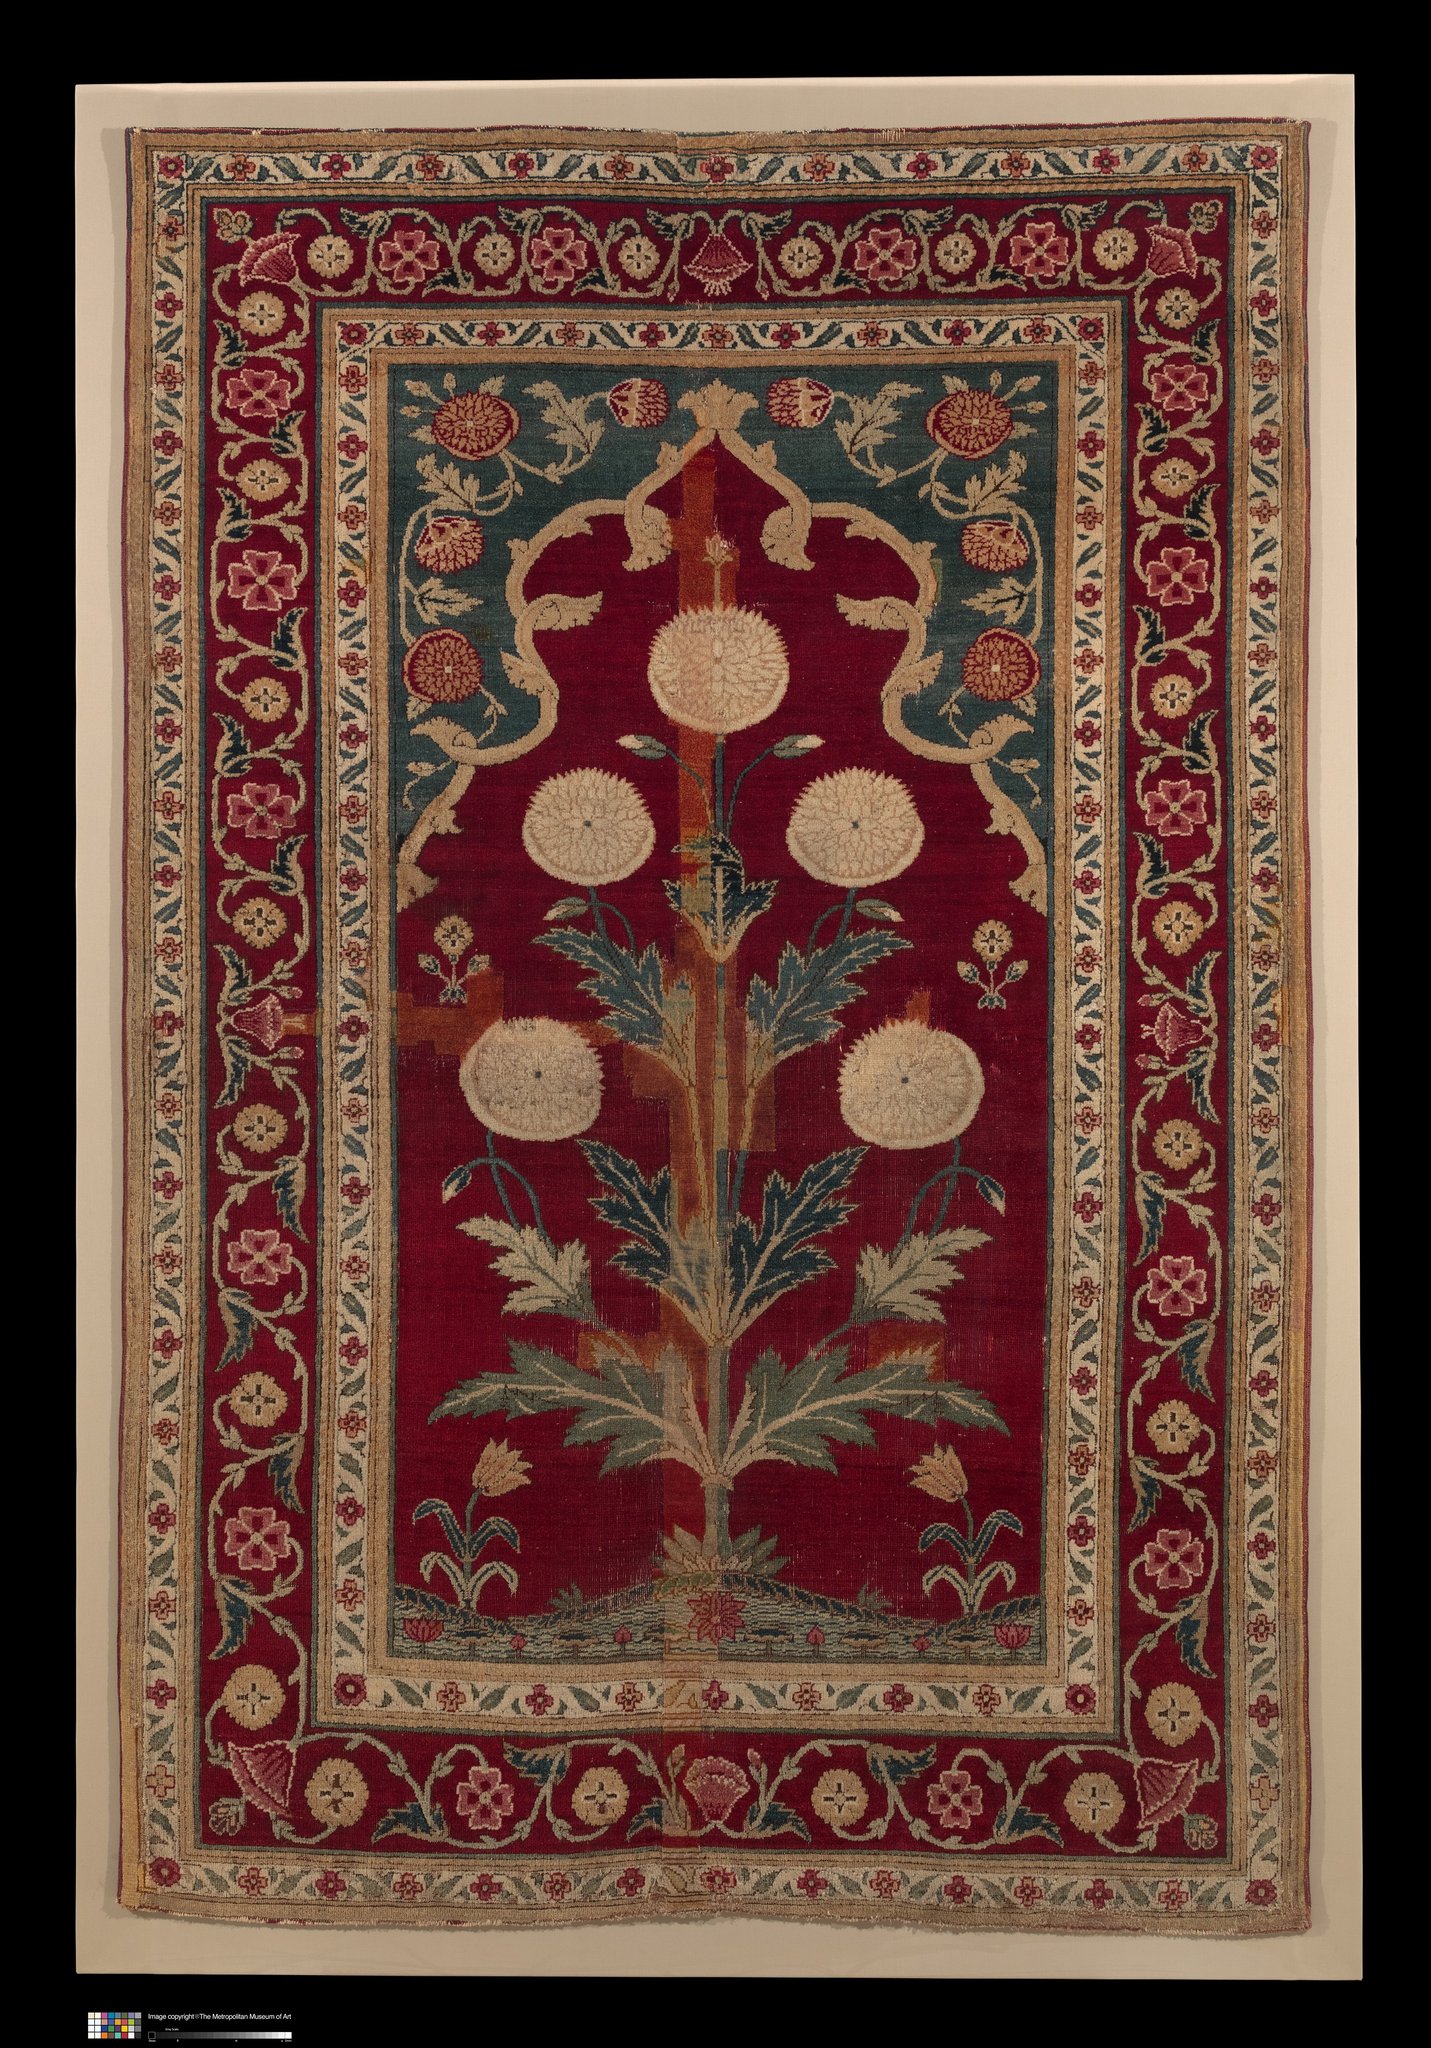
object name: carpet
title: Carpet with Niche and Flower Design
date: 1634-1666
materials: cotton, silk, wool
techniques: asymmetrically knotted pile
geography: india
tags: flowers